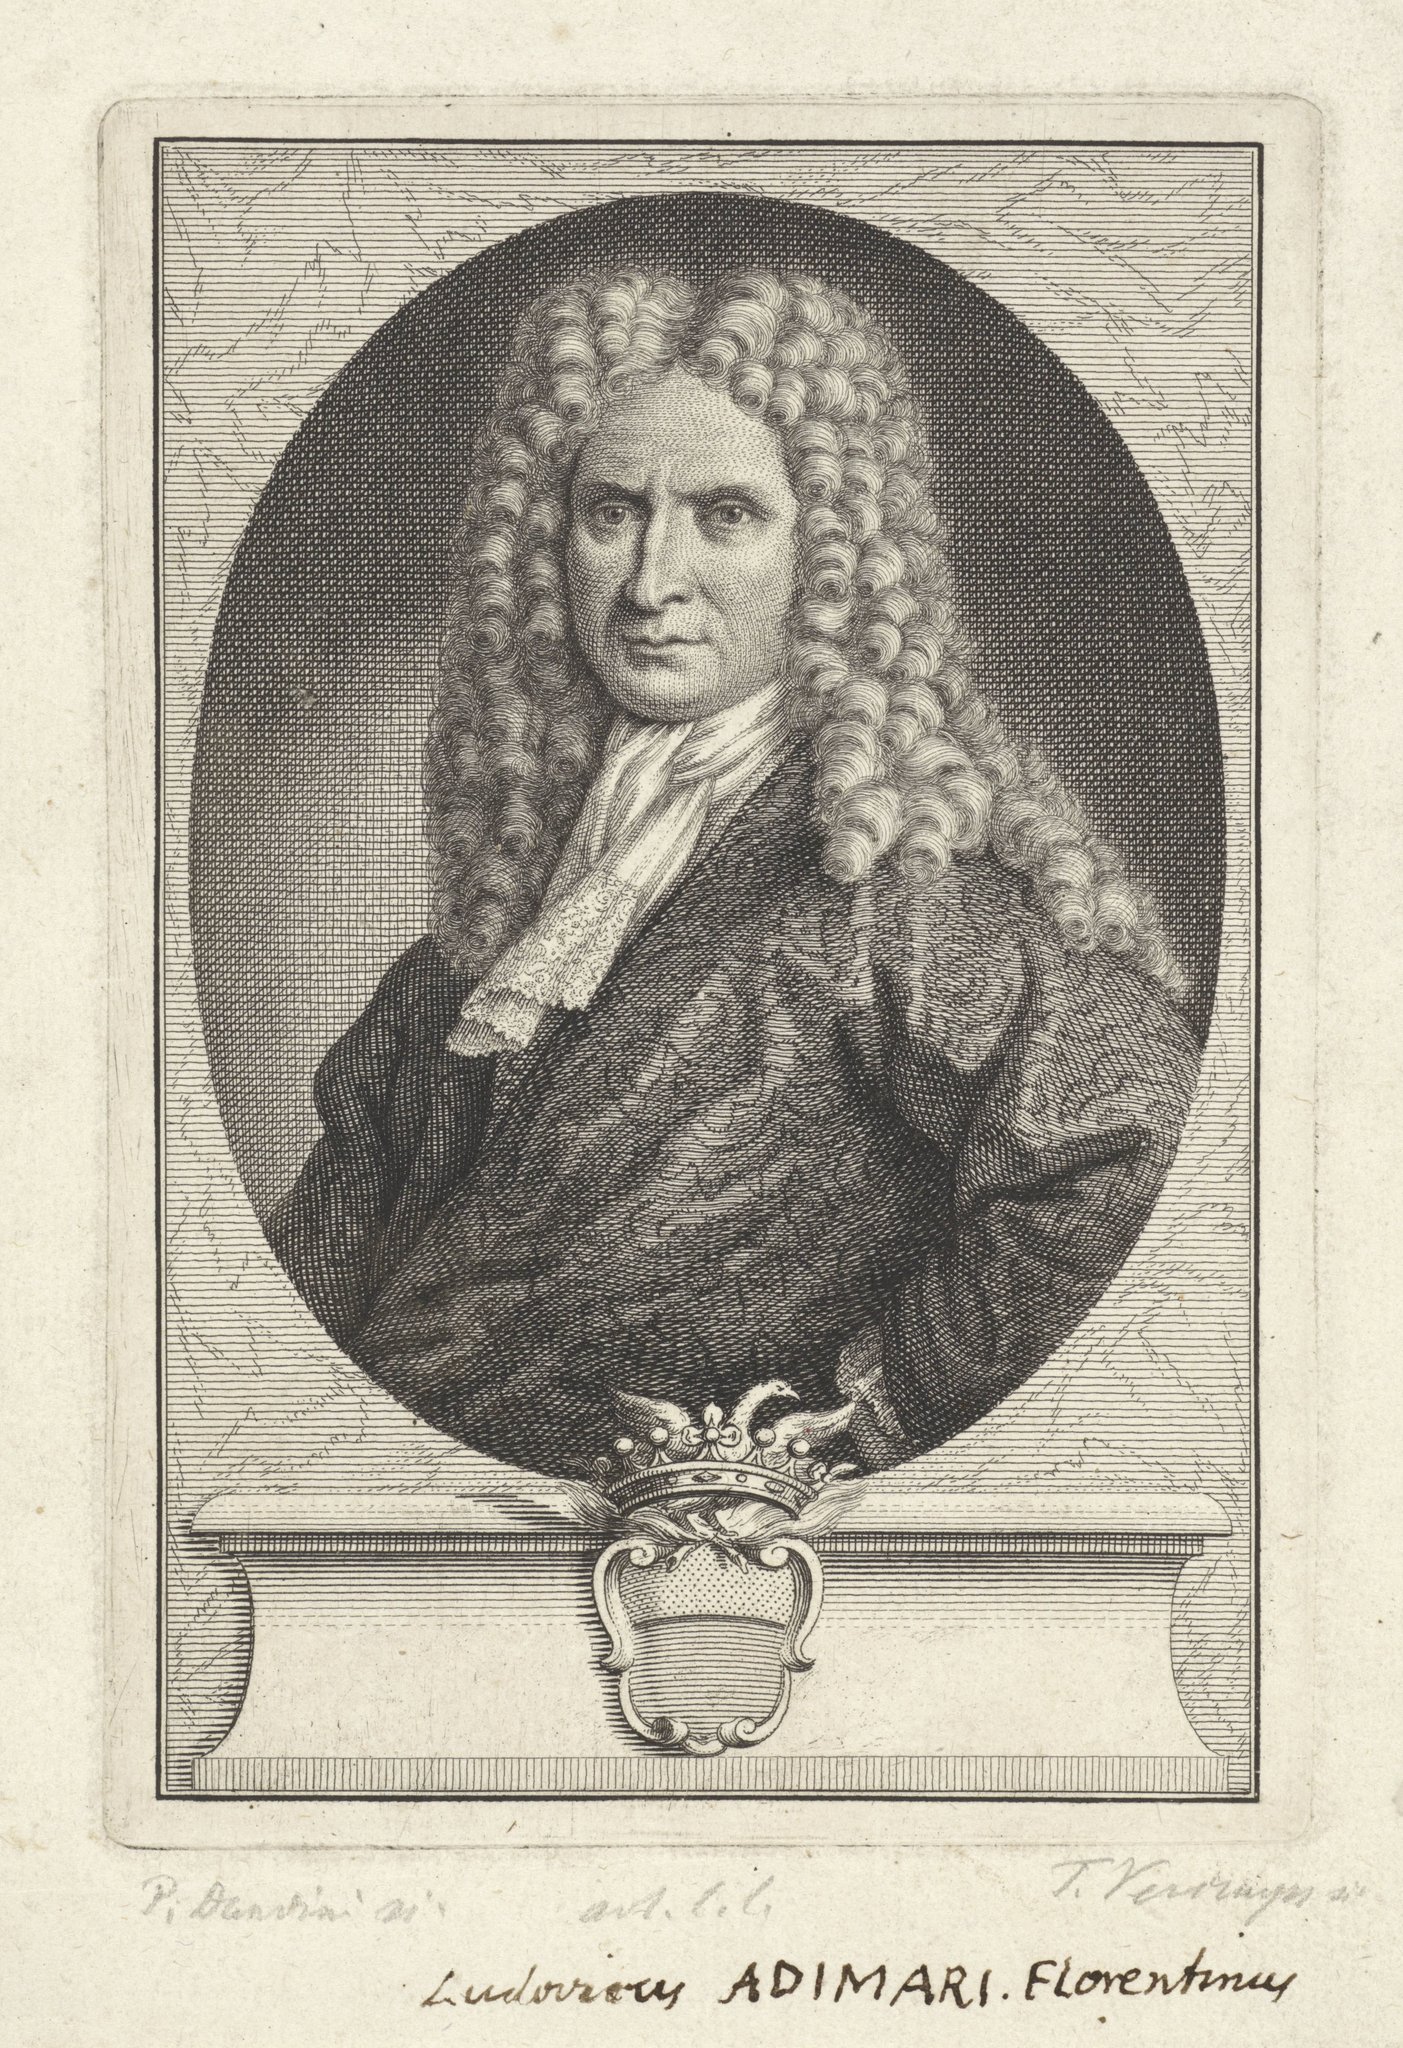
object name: print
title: Portret van Ludovico Adimari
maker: theodor vercruys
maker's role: print maker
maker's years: 1680-1739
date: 1690-1739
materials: paper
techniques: engraving, etching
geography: italy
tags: naples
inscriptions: name: ‘Ludovicus Adimari Florentinus’, collector's mark: Lugt 2228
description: Portret van de Italiaanse dichter en toneelschrijver Ludovico Adimari.